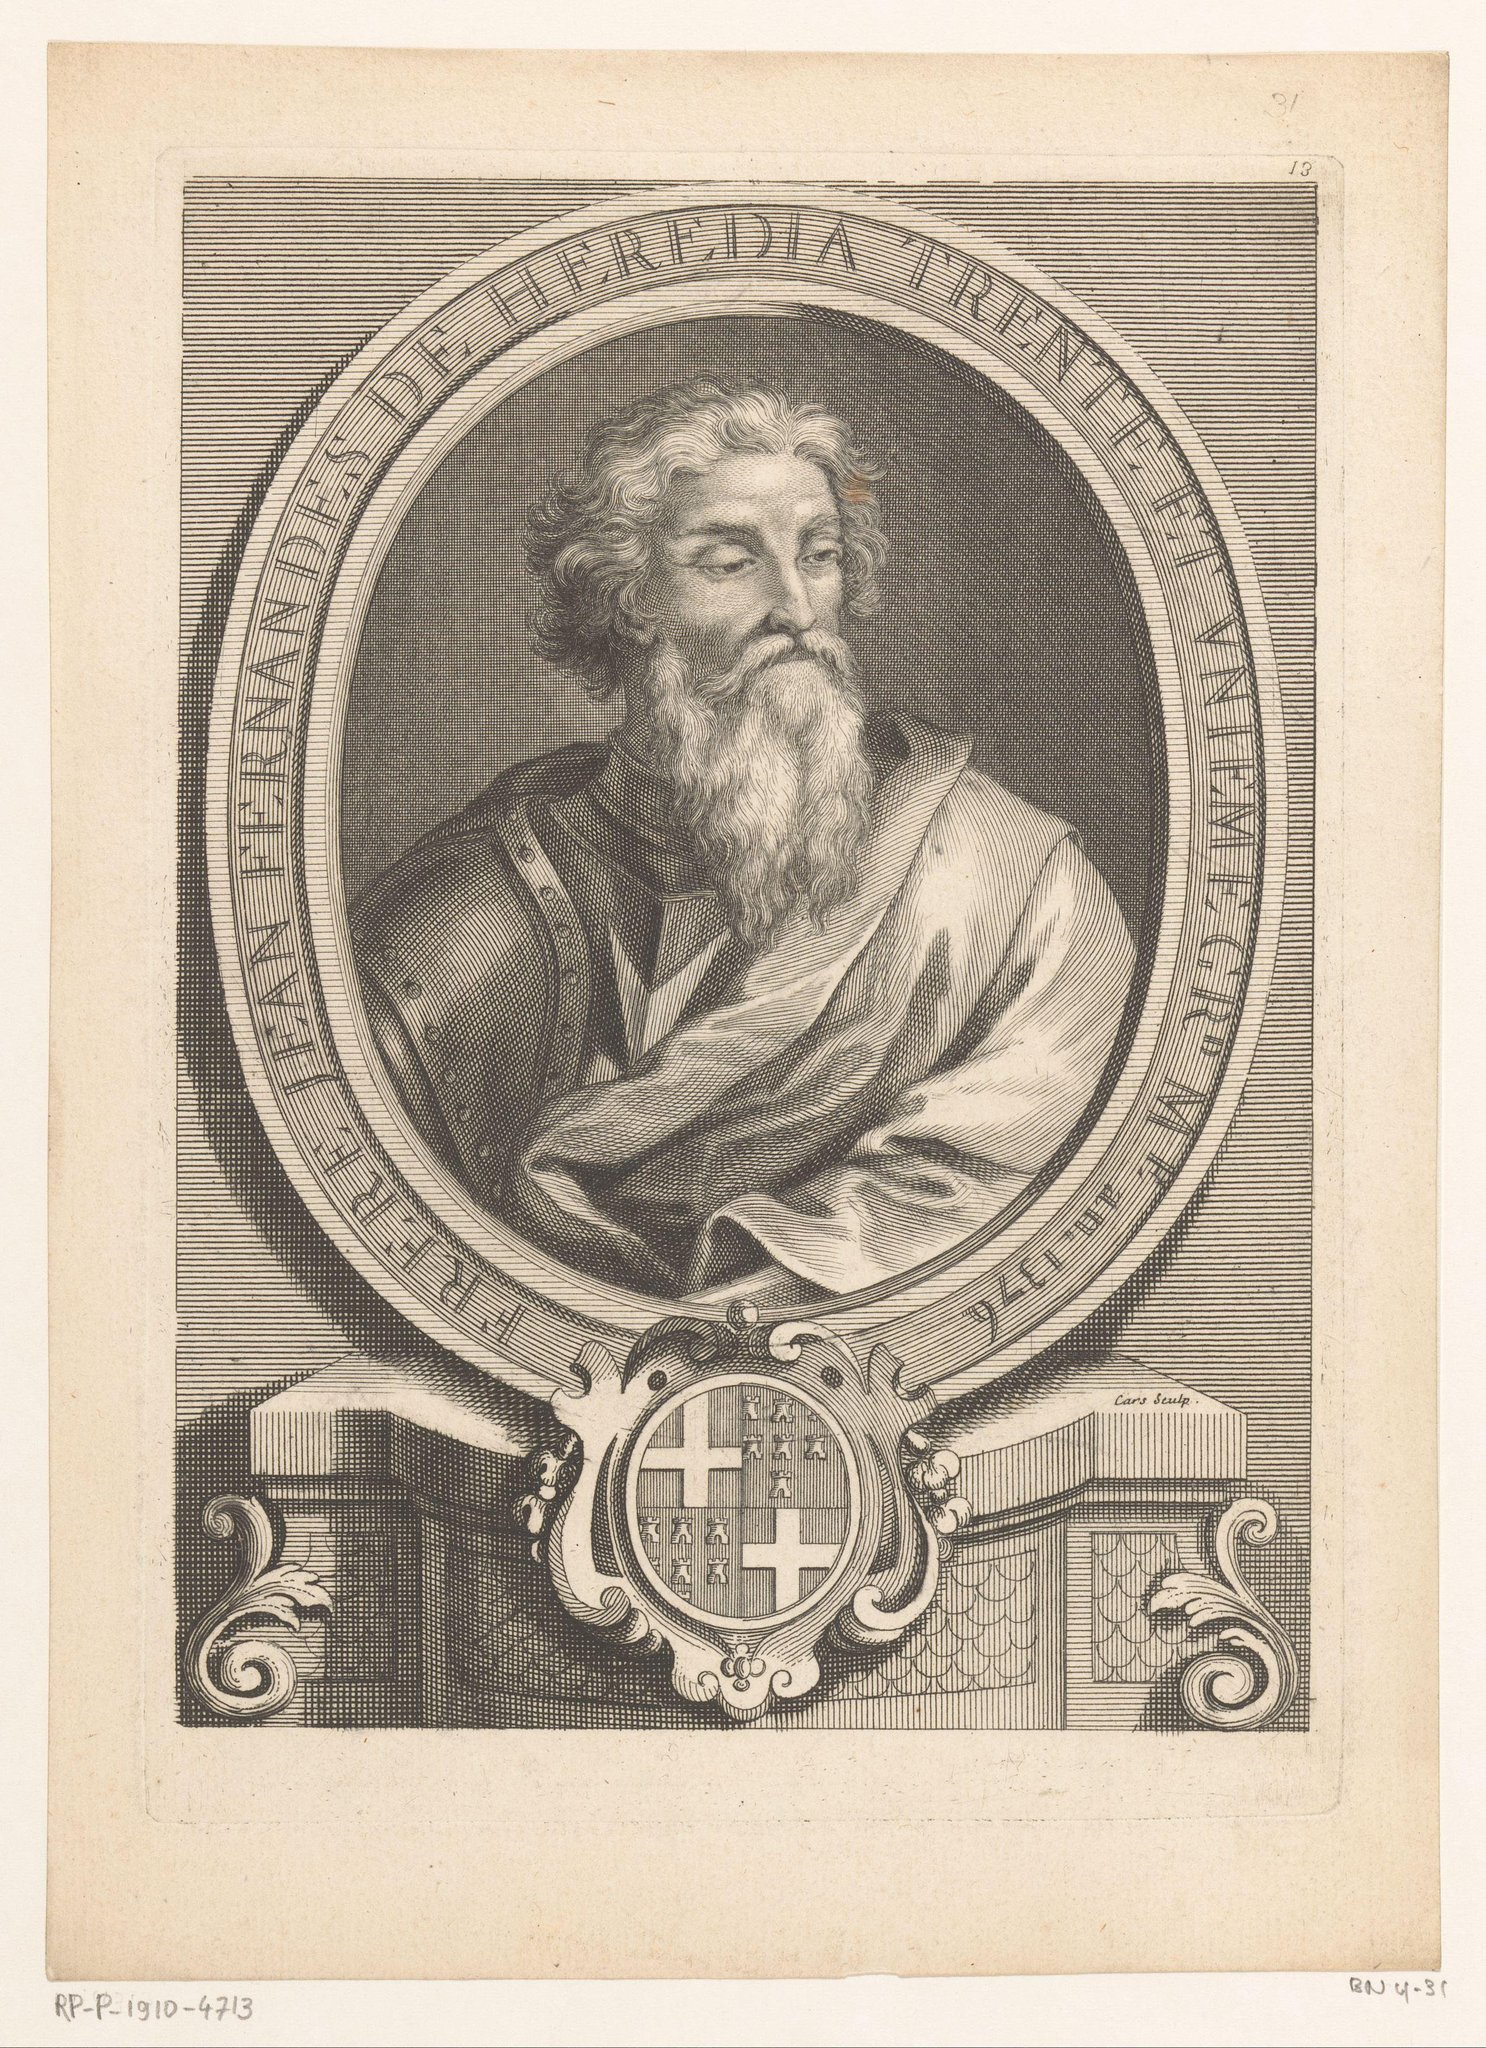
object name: book illustration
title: Portret van Juan Fernández de Heredia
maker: laurent cars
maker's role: print maker, publisher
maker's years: 1699-1771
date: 1726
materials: paper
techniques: engraving, etching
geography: france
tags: historical persons, military orders, e.g.: knights templars, knights of malta, teutonic knights ~ roman catholic church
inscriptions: collector's mark: Lugt 2228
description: Prent uit: Vertot, René Aubert de. Histoire des Chevaliers hospitaliers de St Jean de Jérusalem. Parijs: Rollin, Quillau, Desaint, 1726. Illustratie op p. 79 van deel 2. Cars vervaardigde portretten van 65 grootmeesters van de Maltezer Orde.